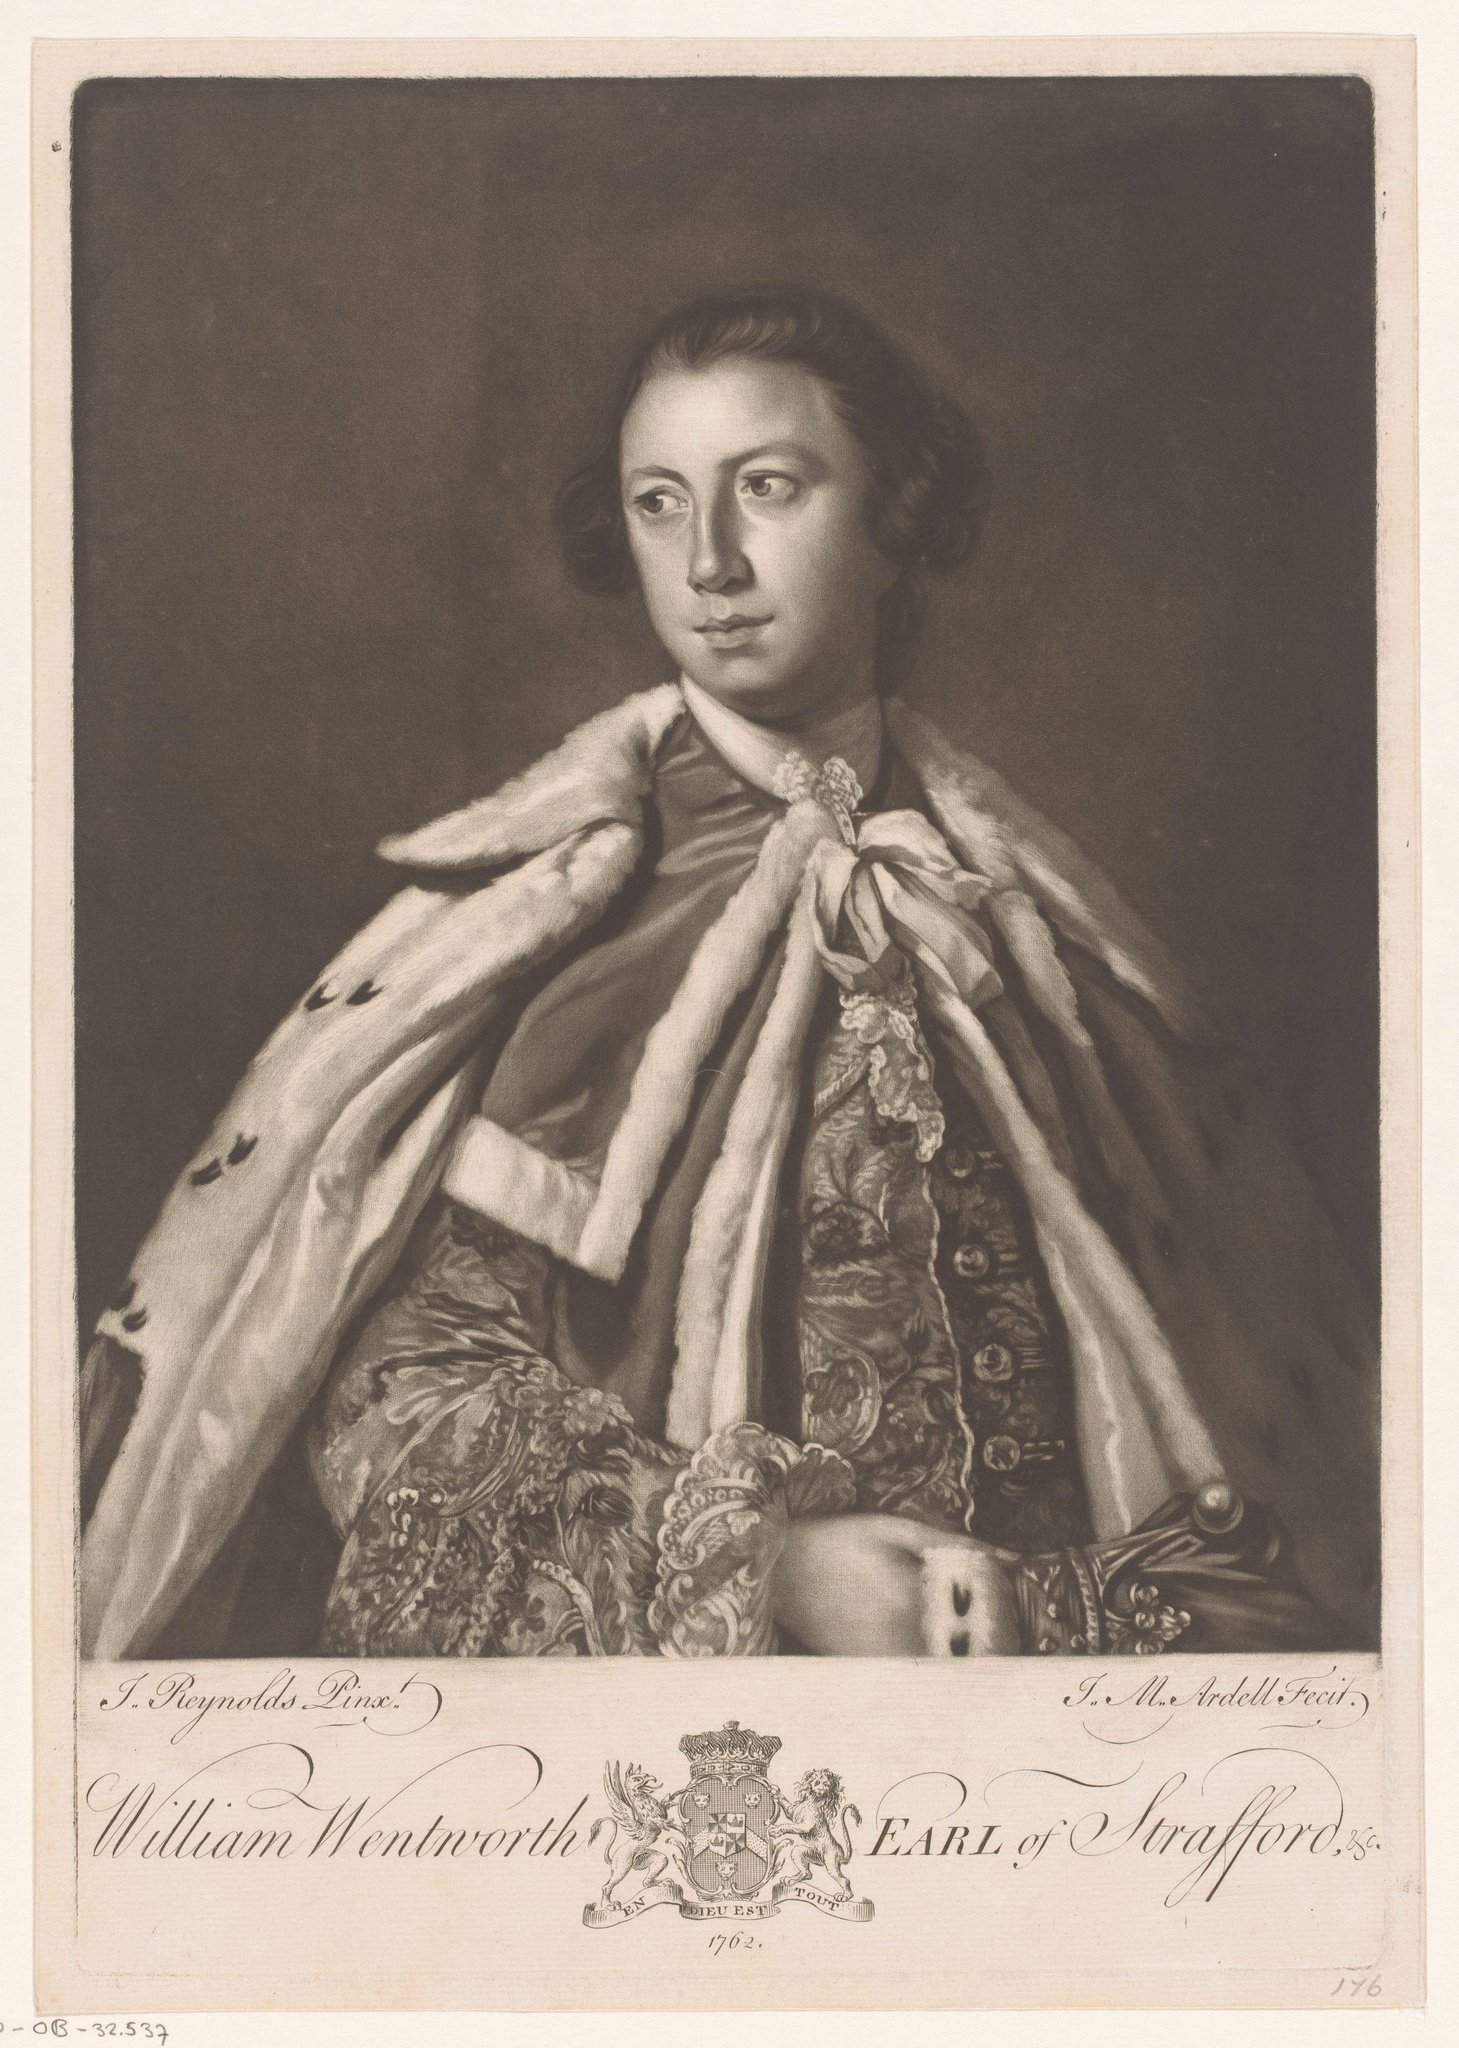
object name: print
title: Portret van William Wentworth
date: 1762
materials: paper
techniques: mezzotint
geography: london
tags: historical persons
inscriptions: collector's mark: Lugt 240